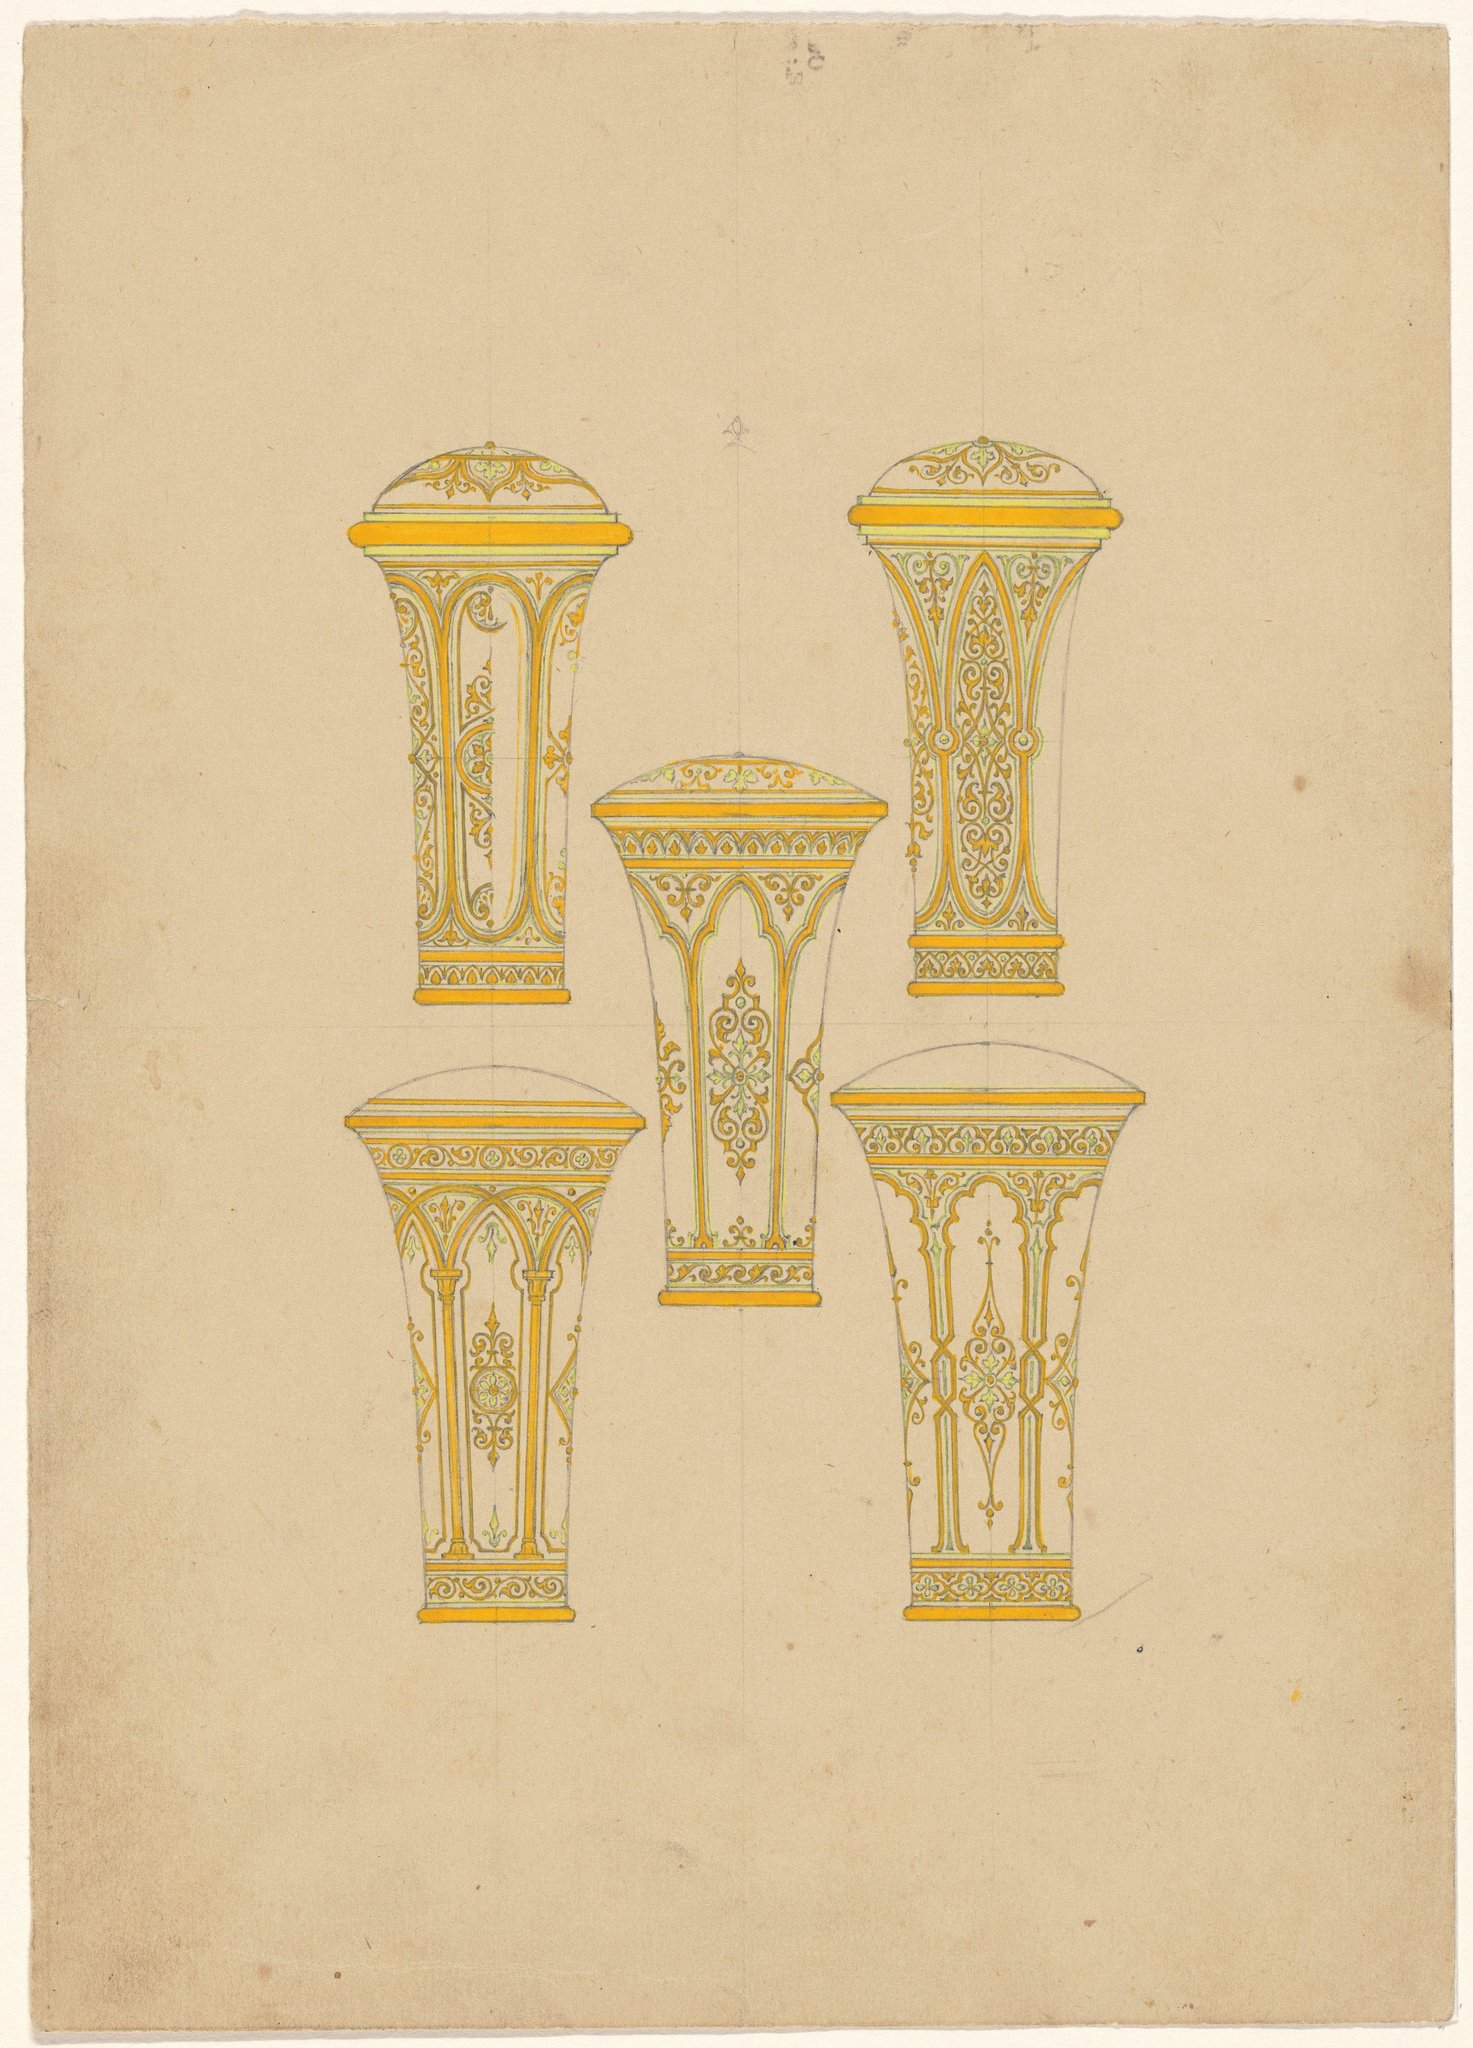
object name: design drawing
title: Vijf wandelstokknoppen van gedamascineerd ijzer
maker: plácido zuloaga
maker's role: sculptor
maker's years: 1833-1910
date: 1870-1880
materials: graphite, paper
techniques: brush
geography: eibar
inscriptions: inscription: ‘Carpeta XVIII / No. 2.473’